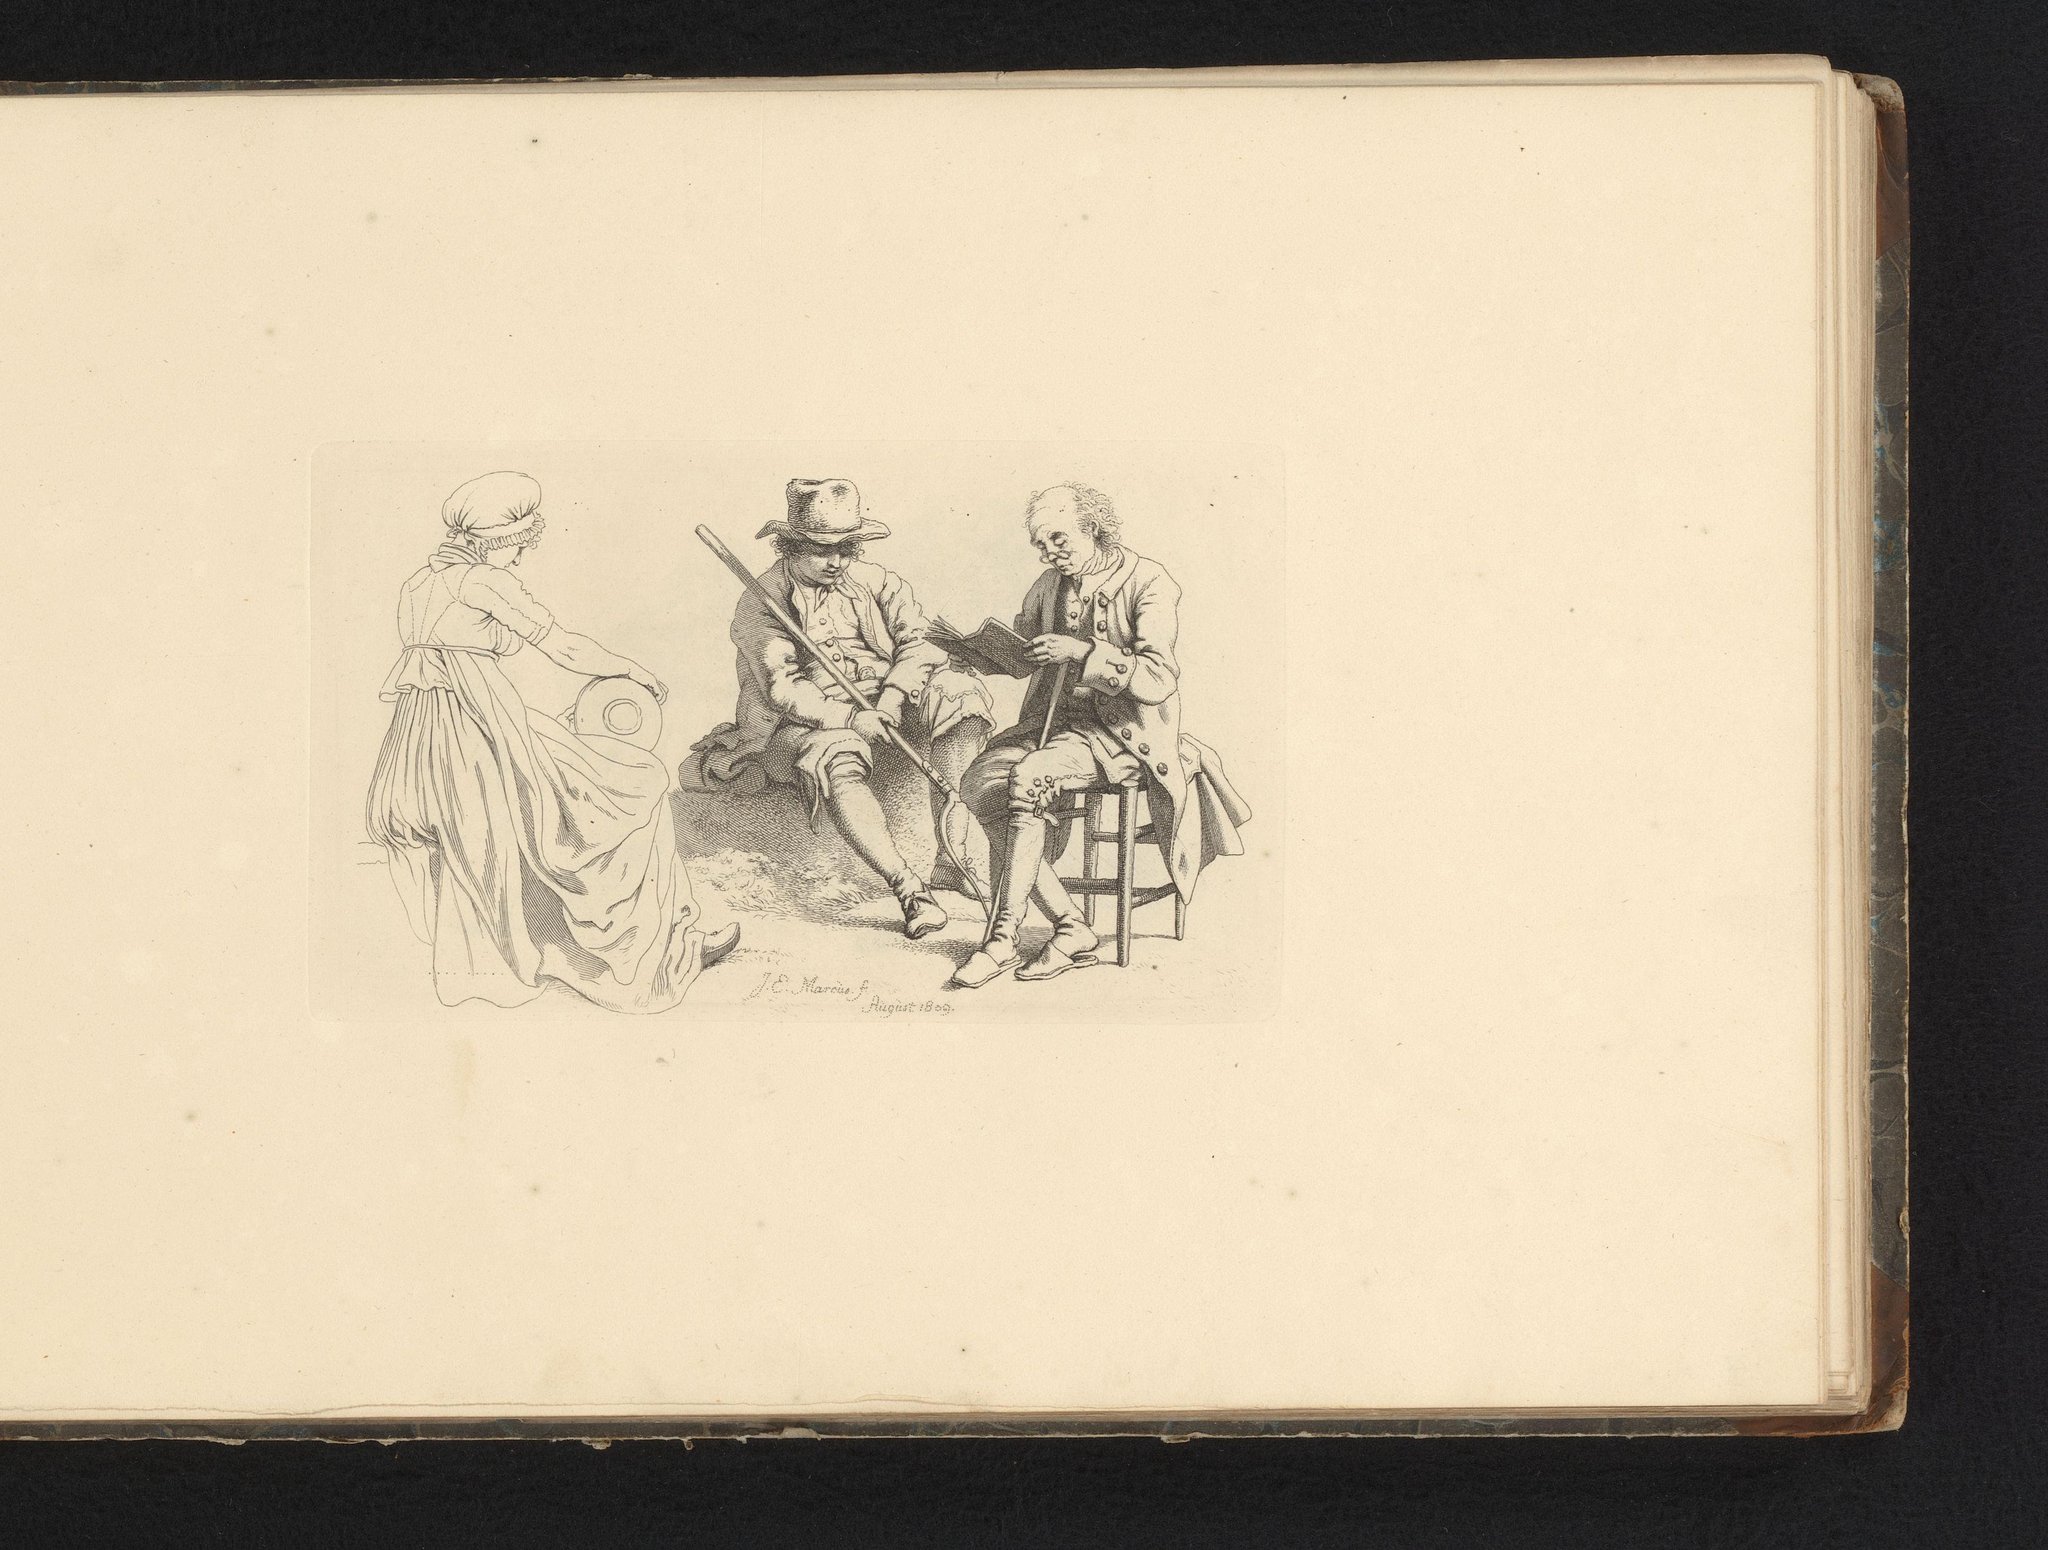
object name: print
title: Studieblad met drie zittende figuren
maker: jacob ernst marcus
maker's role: draughtsman, print maker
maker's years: 1774-1826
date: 1808-1809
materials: paper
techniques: etching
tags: agricultural implements: pitchfork, sitting figure, reading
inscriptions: date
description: Deze prent maakt deel uit van een album.